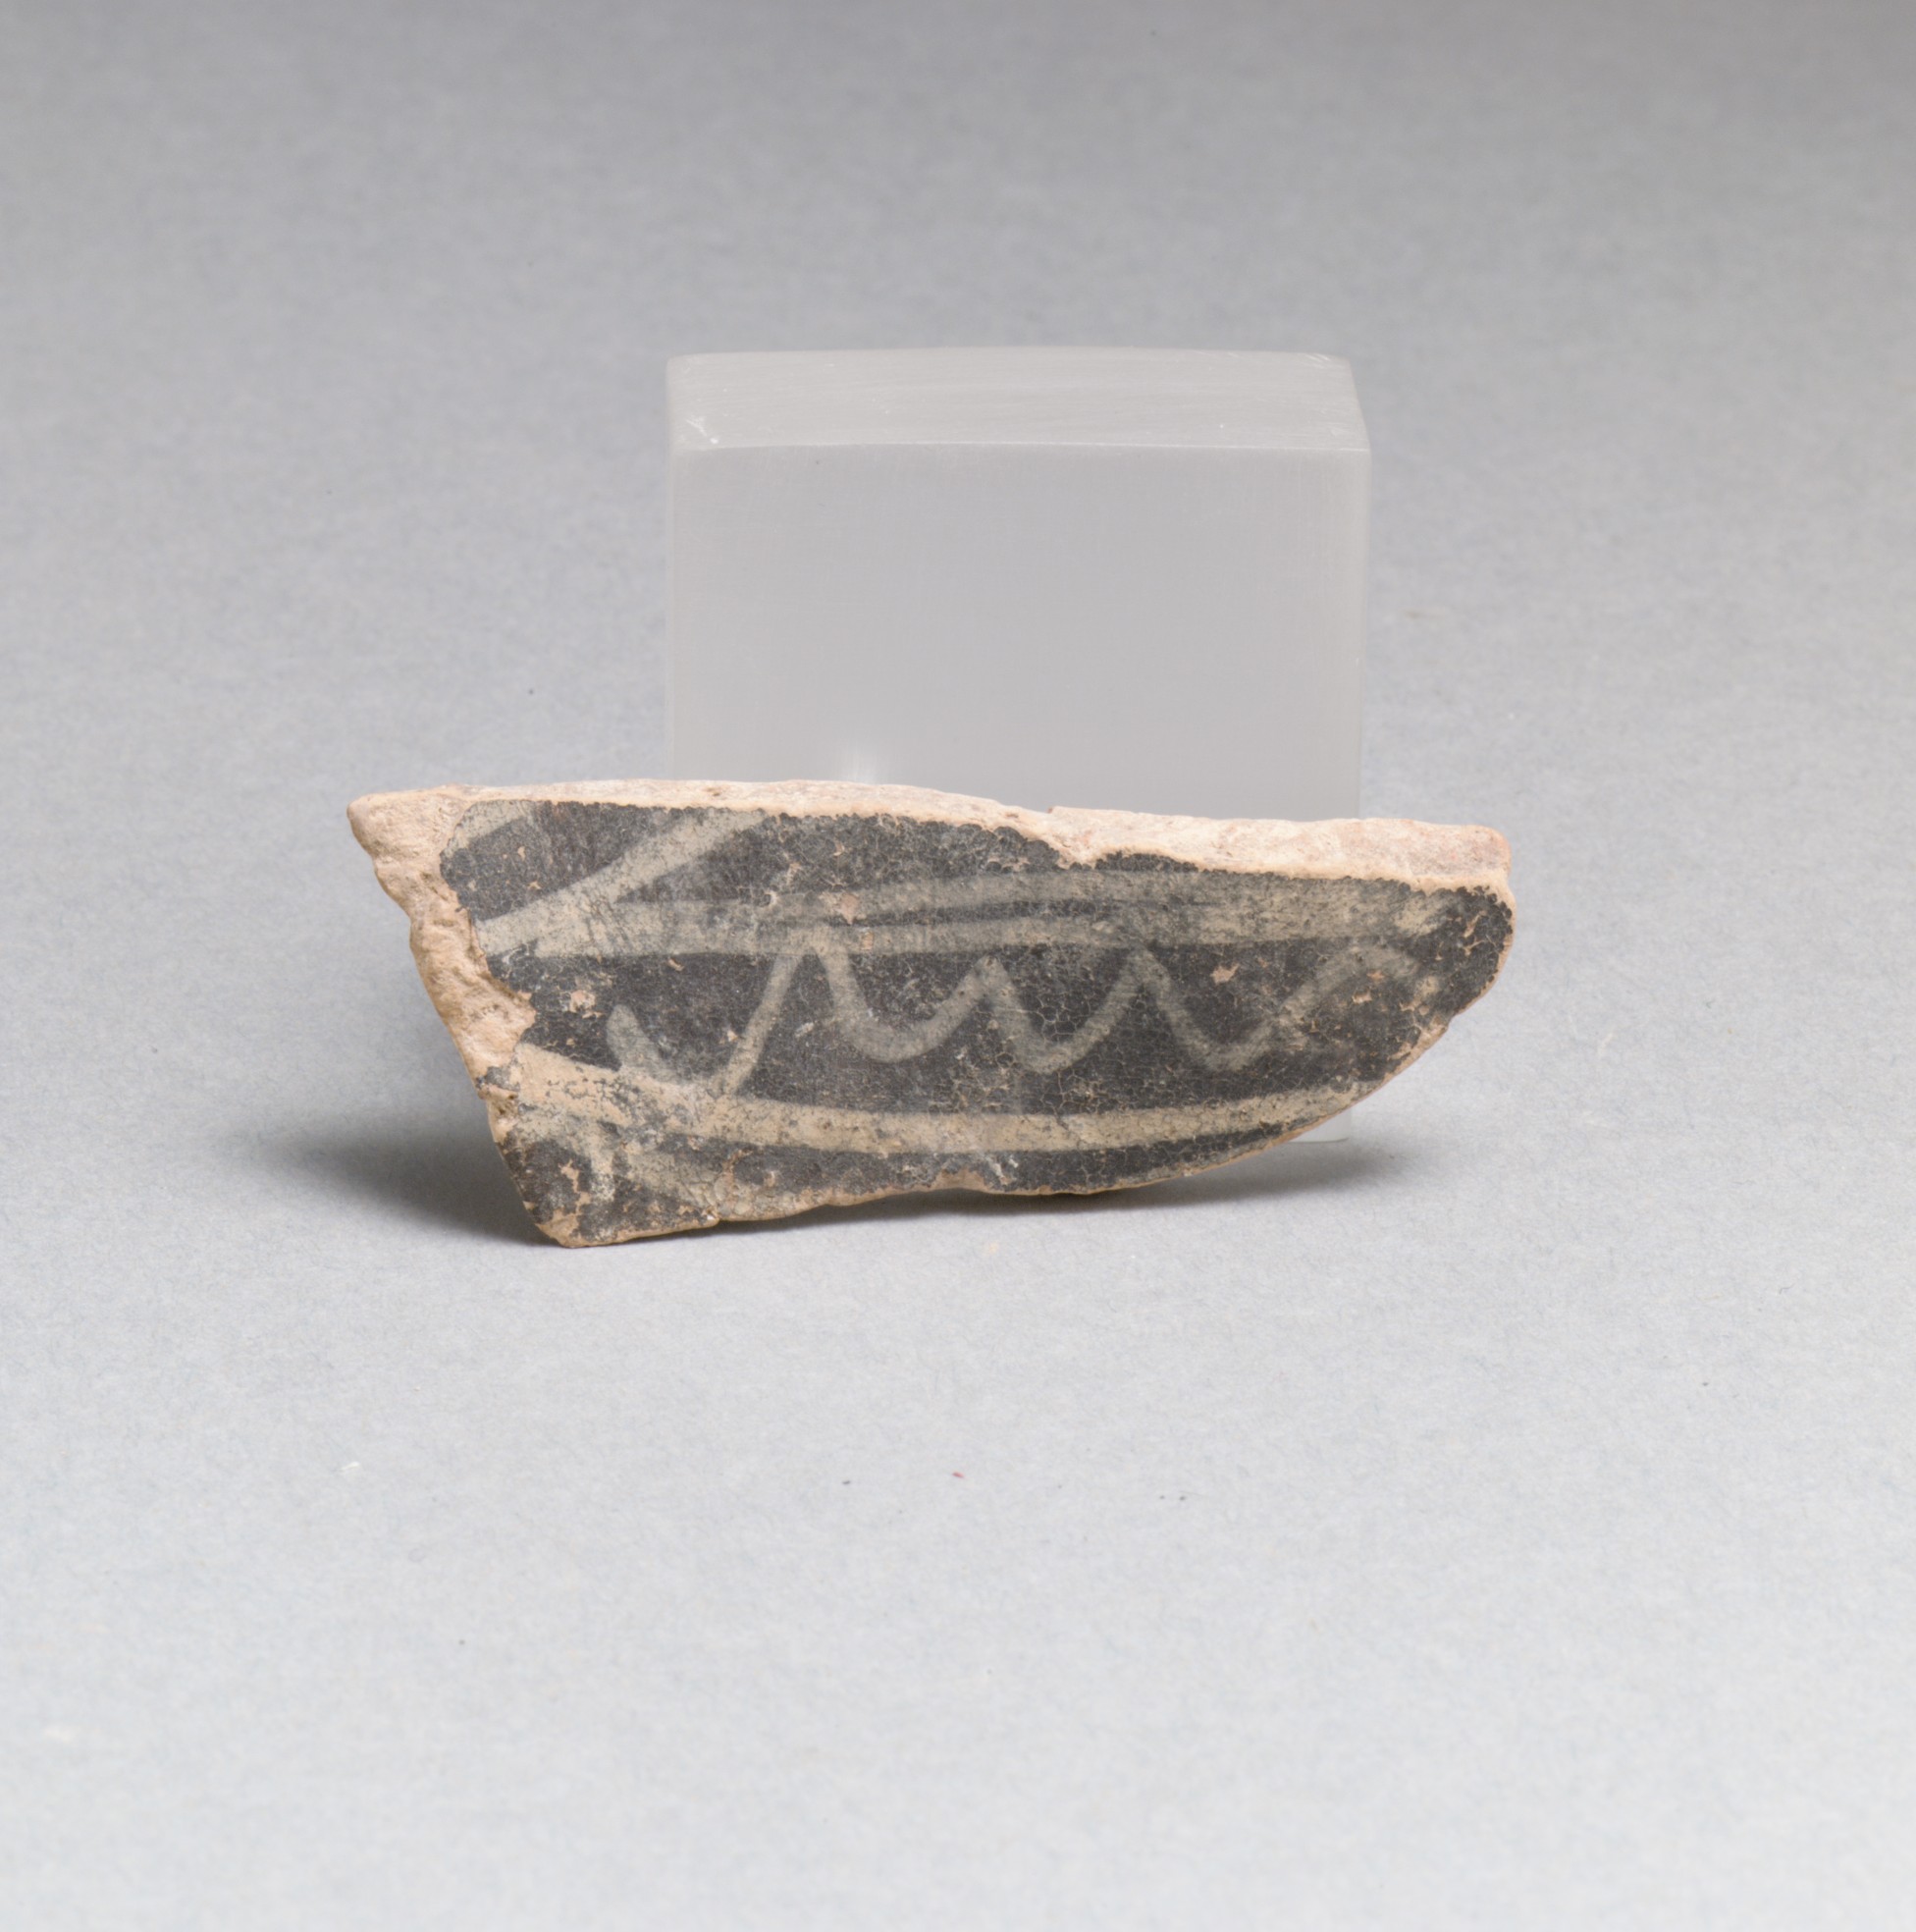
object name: vase fragment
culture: minoan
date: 2600-2000 BCE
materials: terracotta